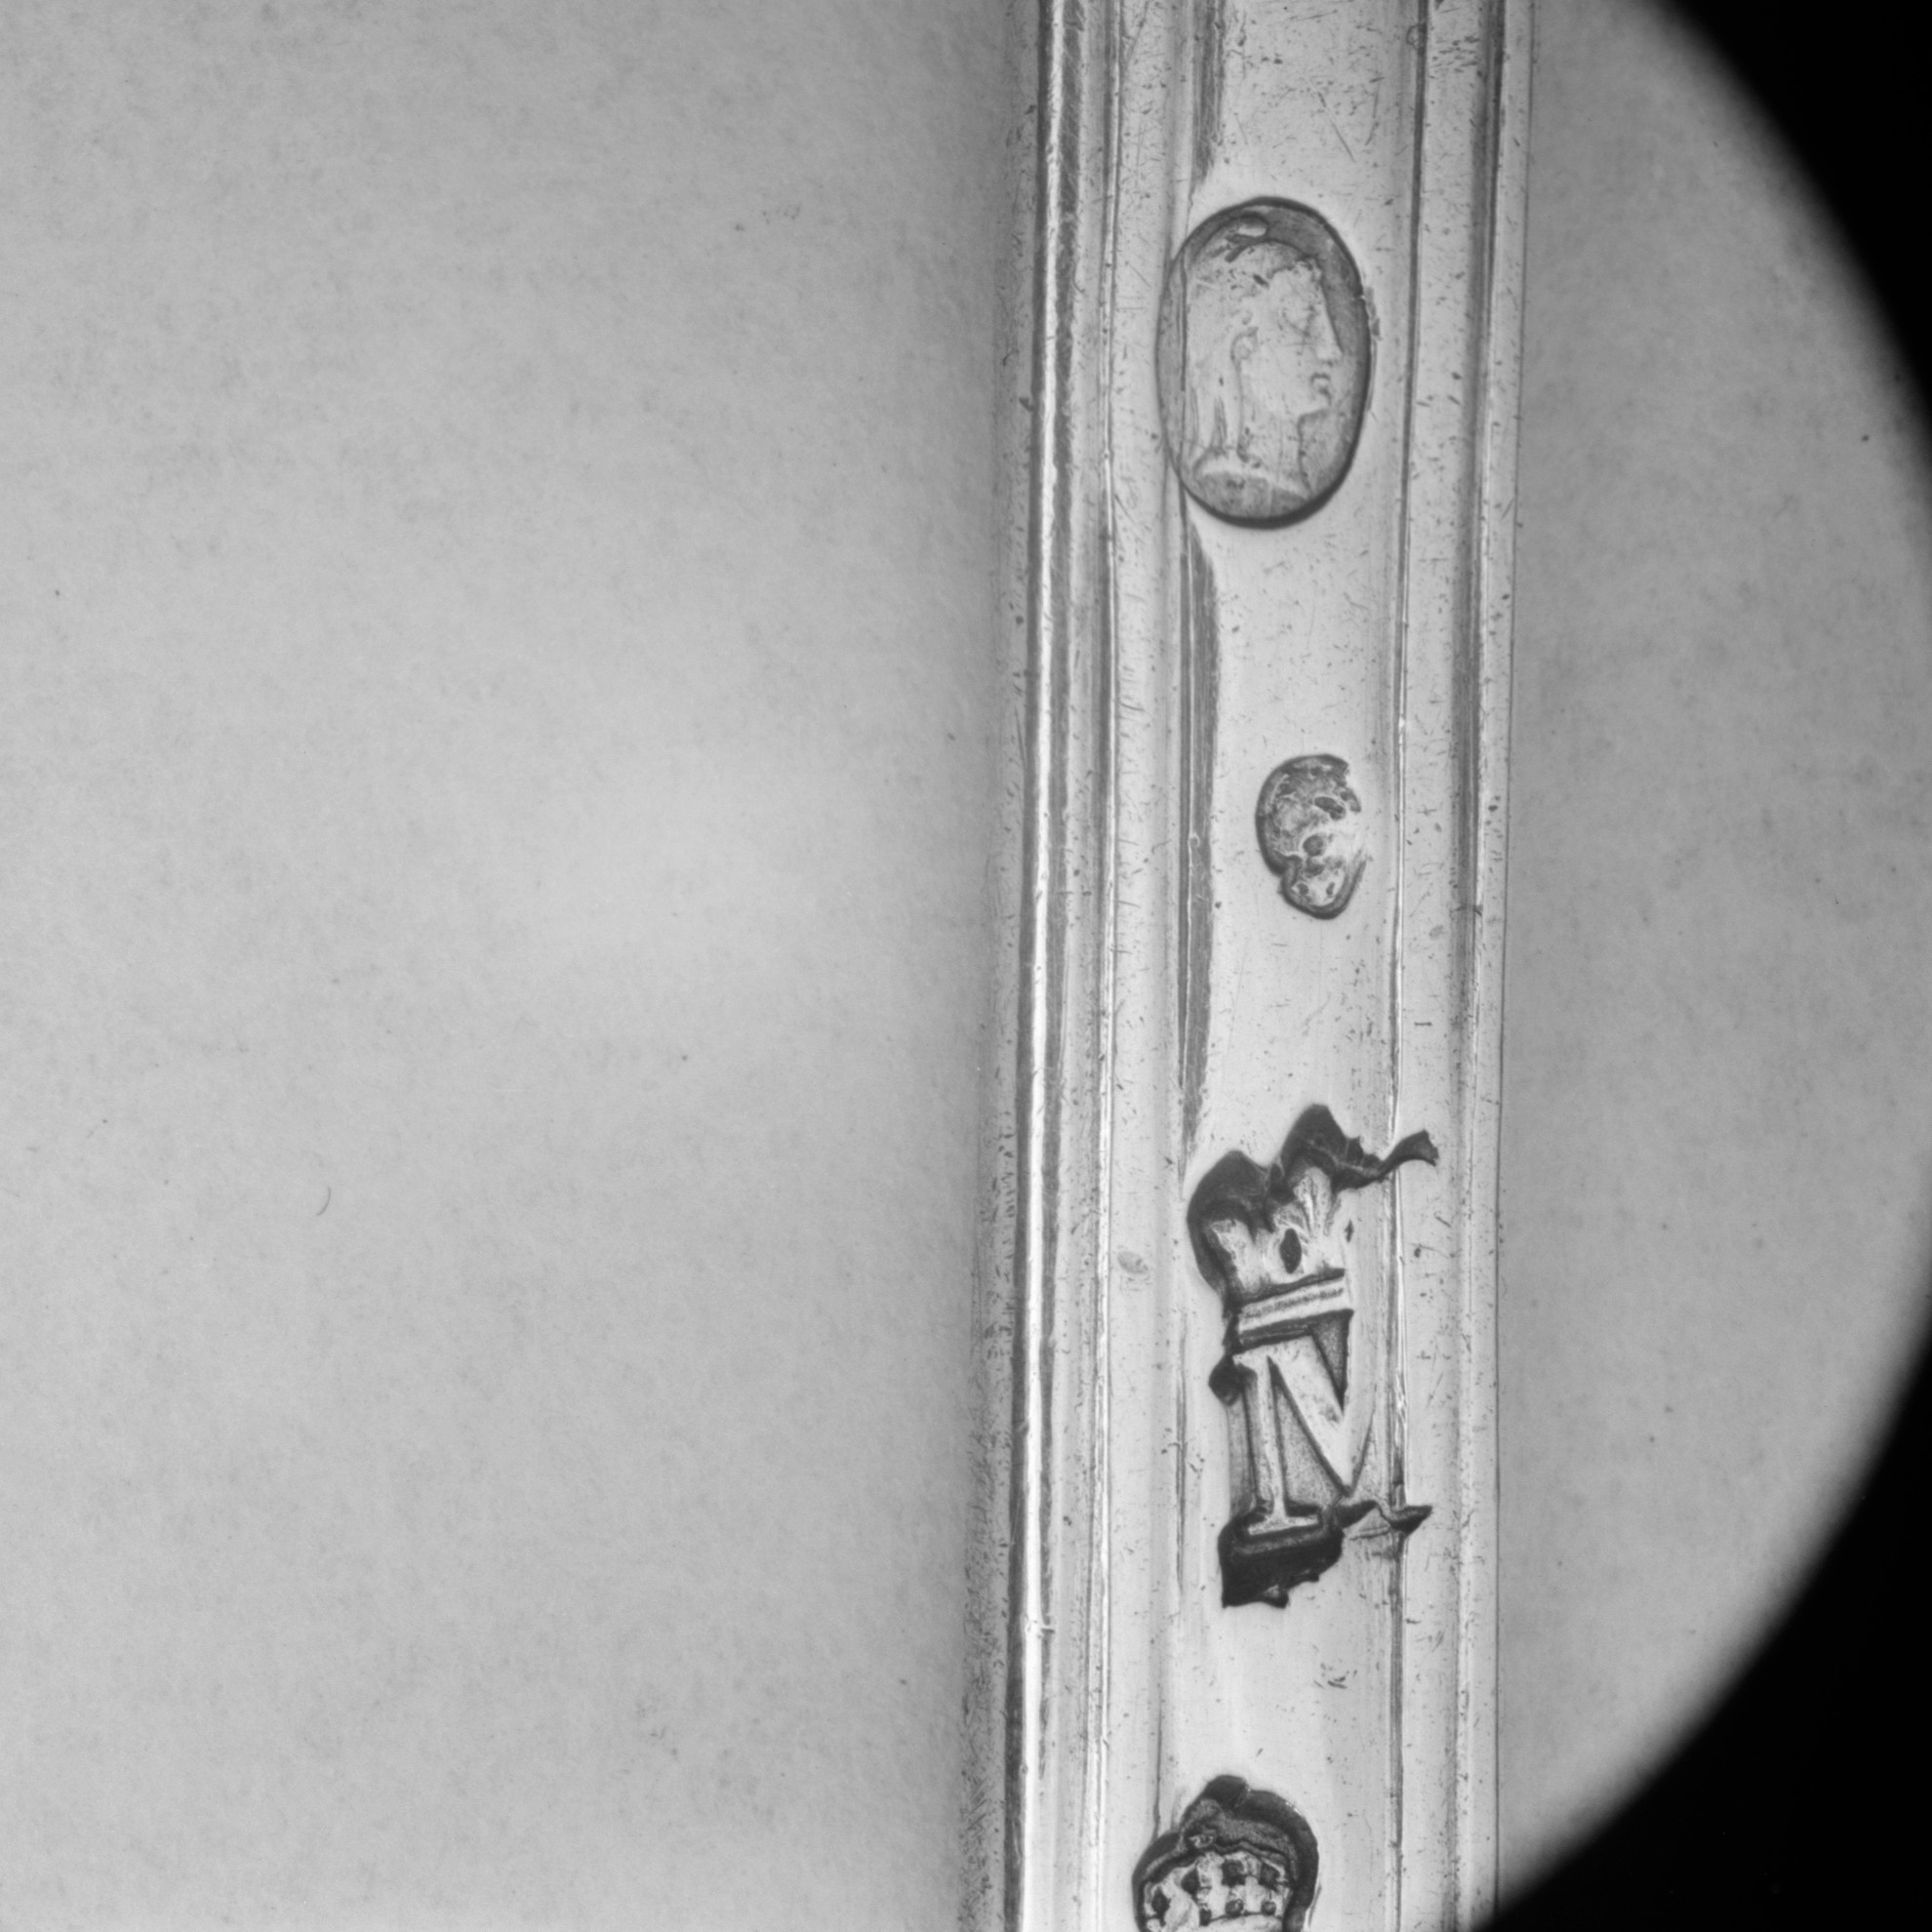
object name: spoon handle section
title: Section of a spoon handle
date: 1775-1776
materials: silver